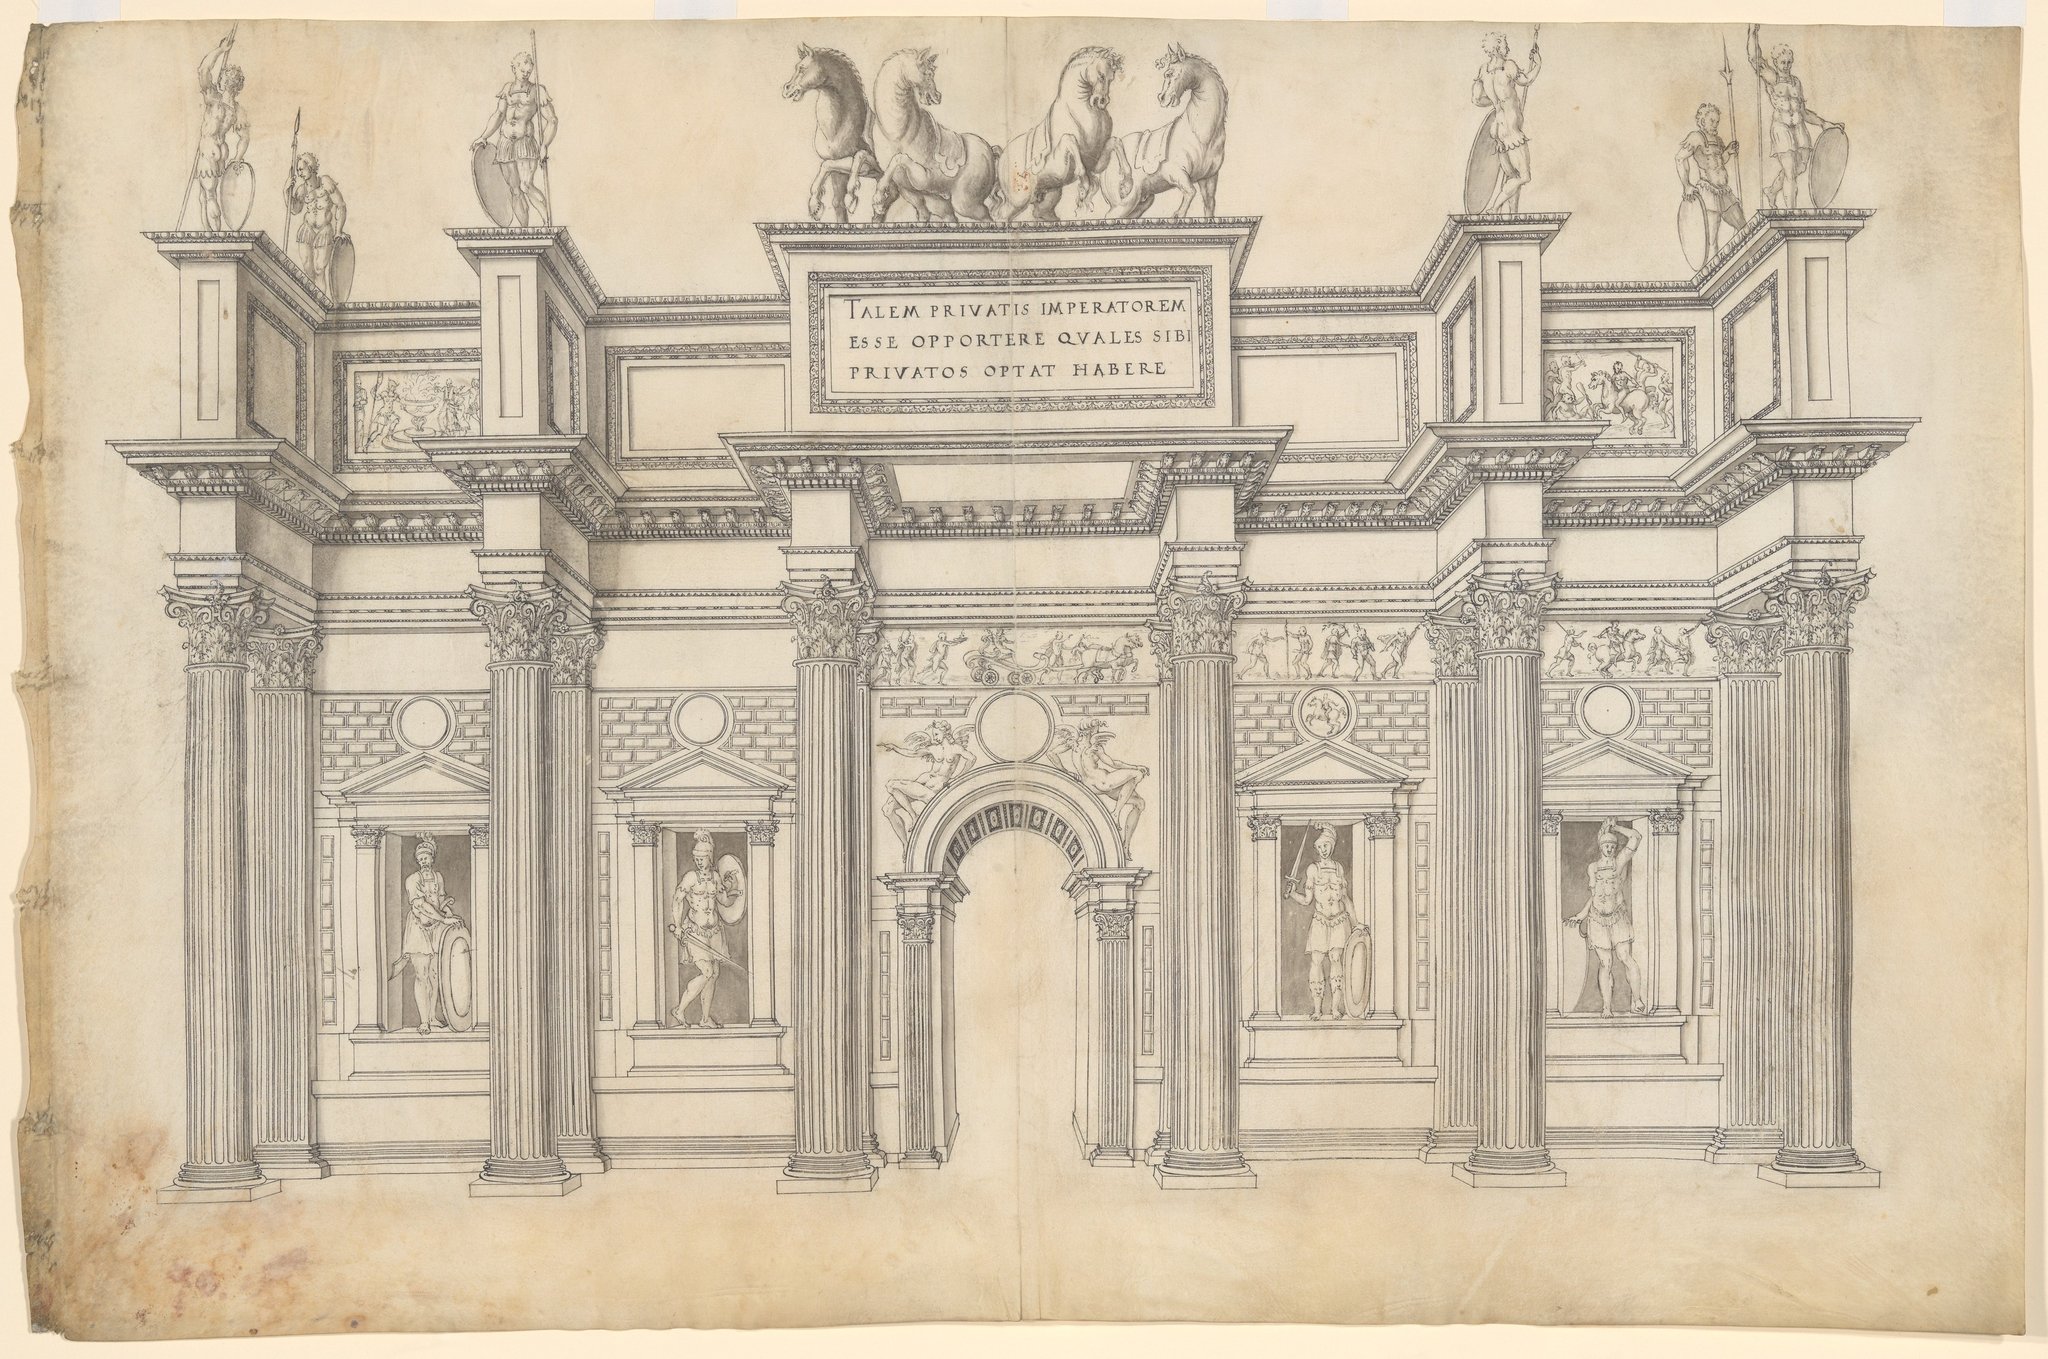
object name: collection ornament architecture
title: A Monumental Archway with Five Bays in the Corinthian Order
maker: jacques androuet du cerceau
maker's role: artist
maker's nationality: french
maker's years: 1510-1585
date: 1501-1600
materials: chalk, ink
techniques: pen, wash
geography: france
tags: architecture